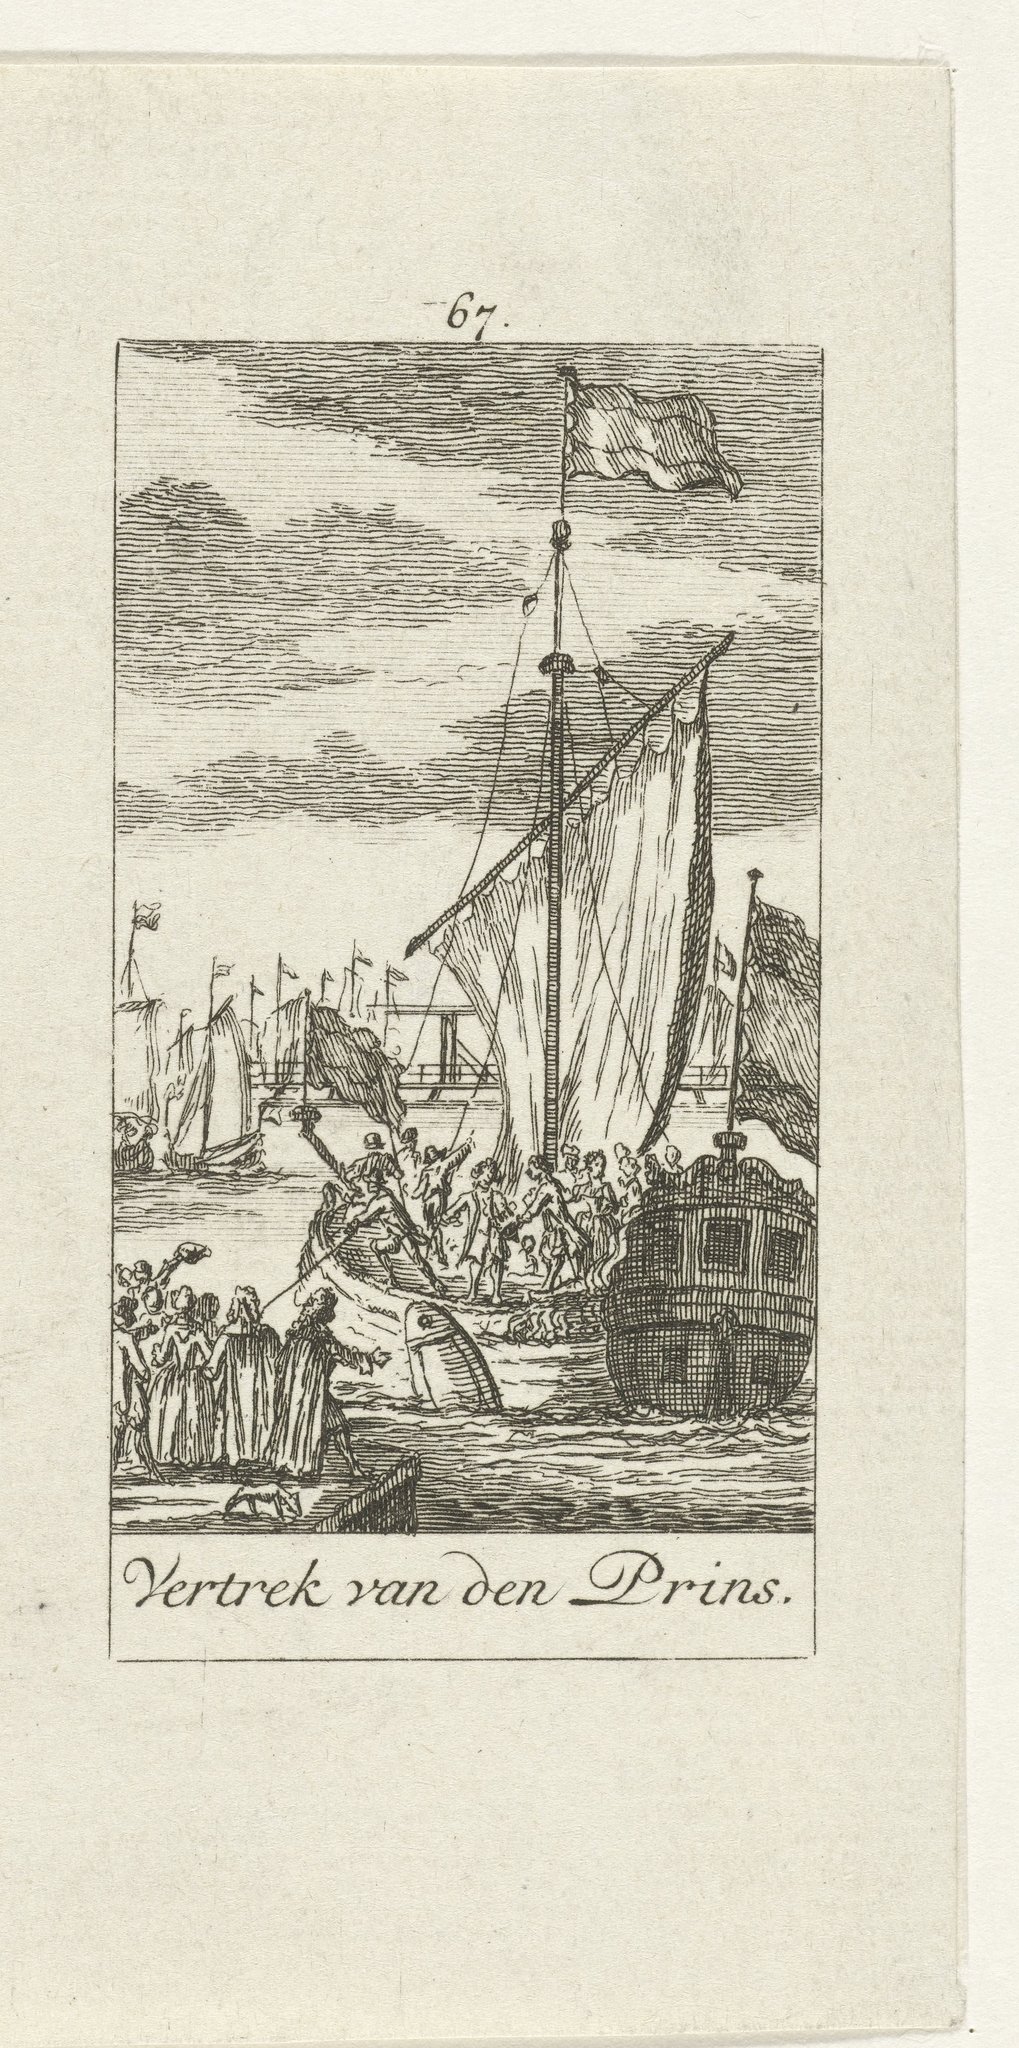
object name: print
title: Vertrek van den Prins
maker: simon fokke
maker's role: draughtsman, print maker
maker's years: 1712-1784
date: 1722-1784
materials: paper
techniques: etching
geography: amsterdam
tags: the hague, william iii (prince of orange and king of england, scotland, and ireland), departure ~ travelling, hellevoetsluis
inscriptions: collector's mark: Lugt 2228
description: Gezicht op de vloot van Willem III, prins van Oranje voor Hellevoetsluis. Willem III is aan boord van een schip gestapt en wordt uitgezwaaid door figuren op de kade. Prent middenboven gemerkt: 67.